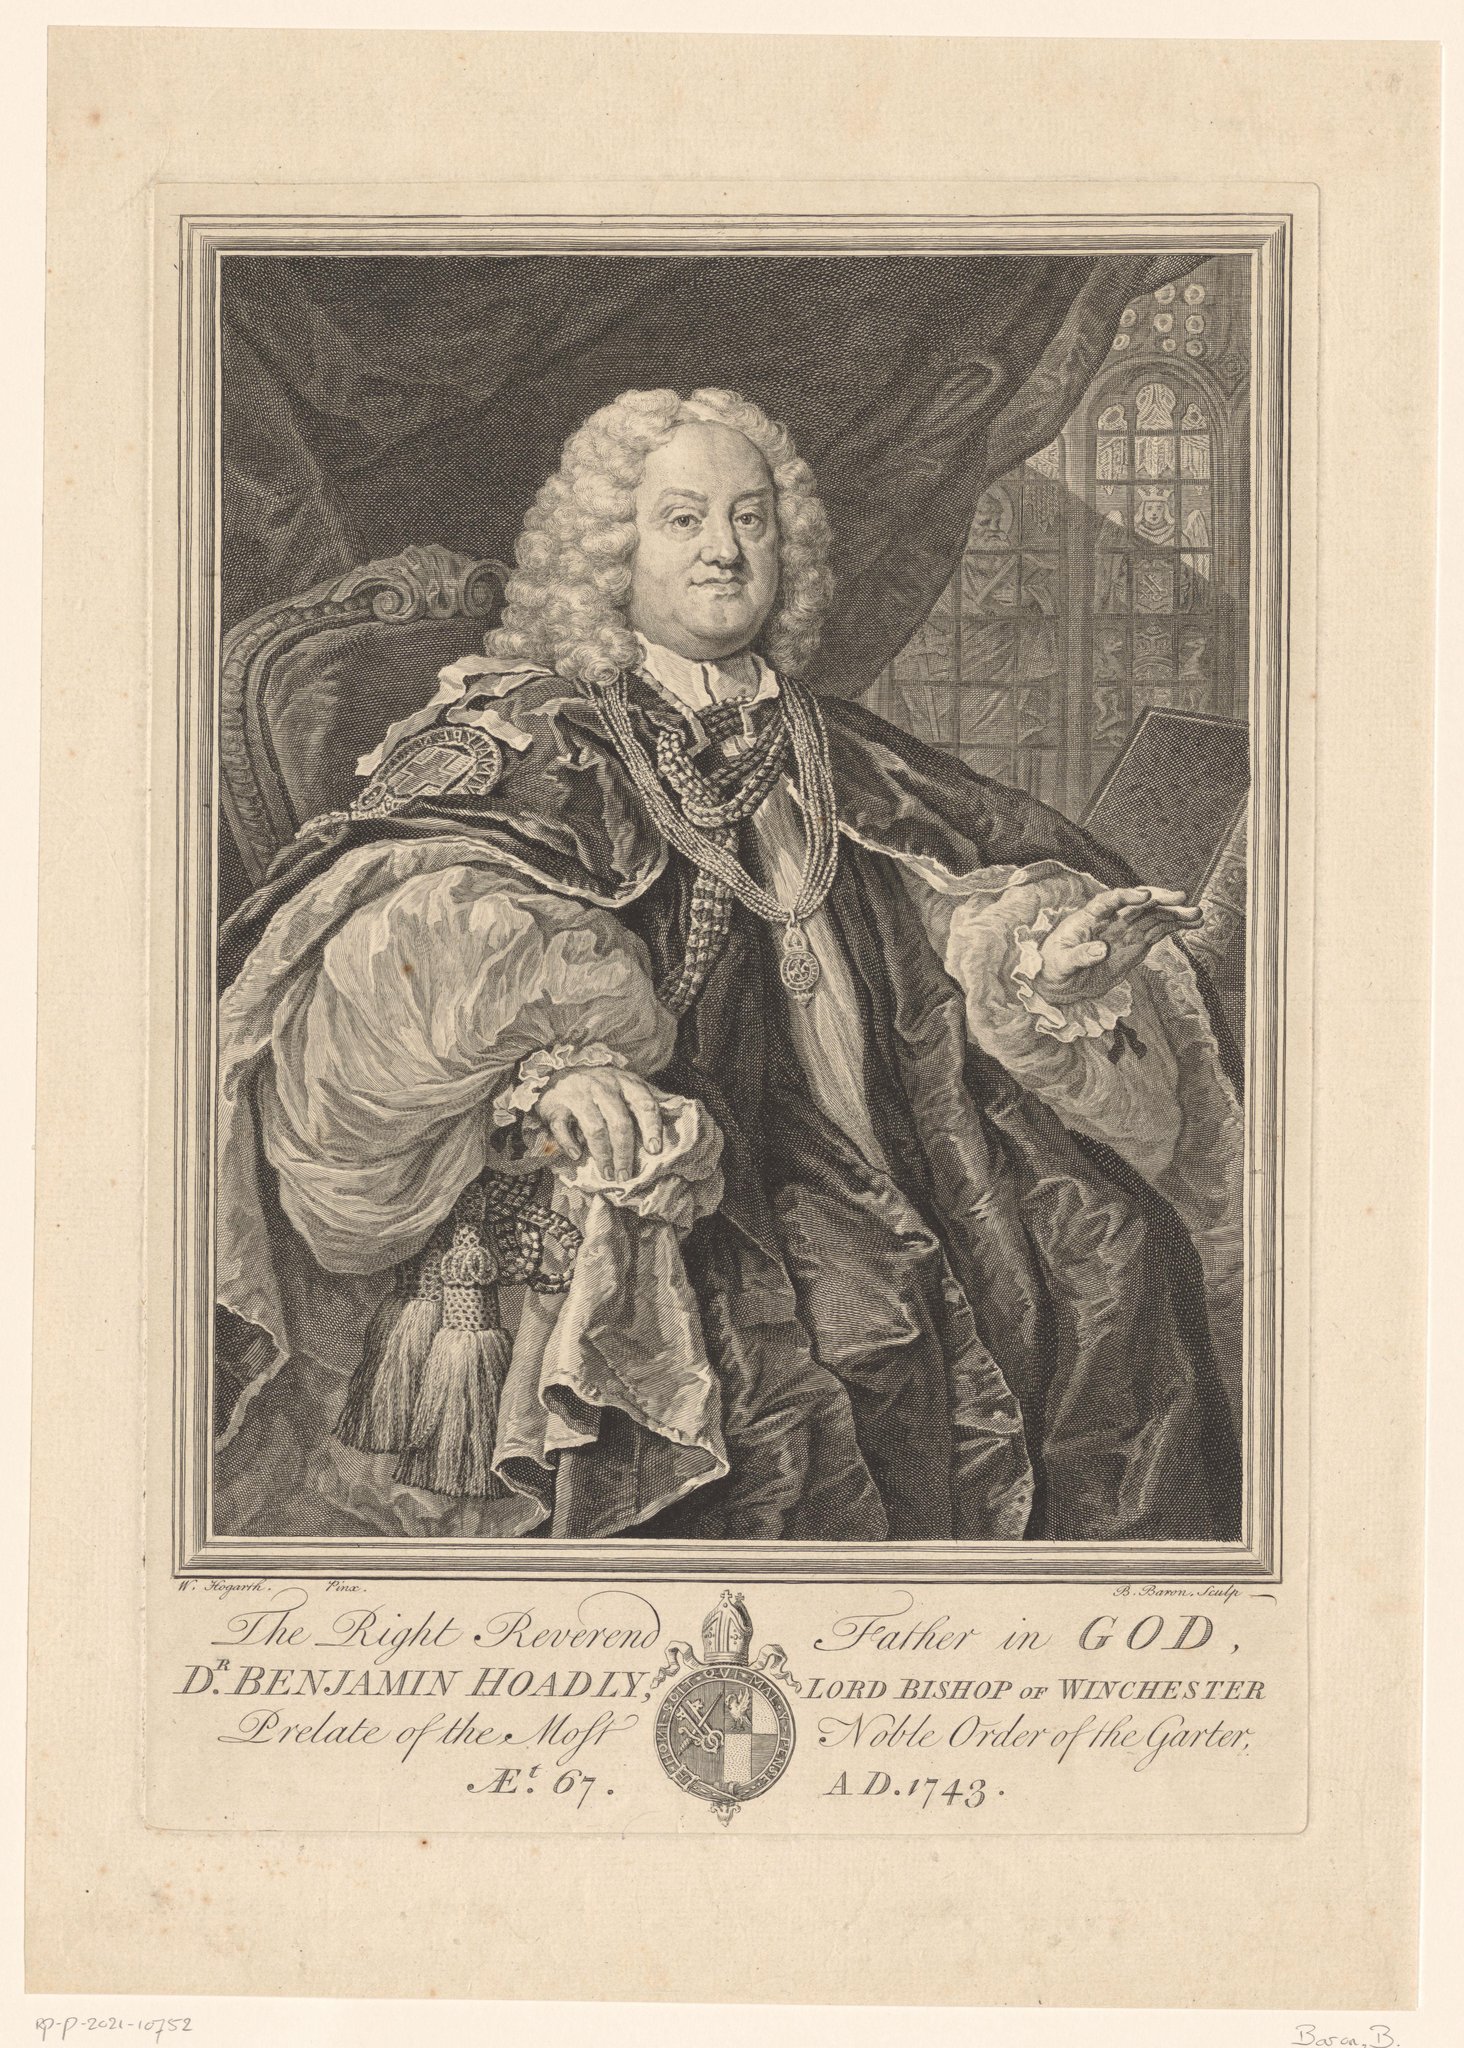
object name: print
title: Portret van Benjamin Hoadly, bisschop van Winchester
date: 1743-1762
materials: paper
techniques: engraving, etching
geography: france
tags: archbishop, bishop, etc. (roman catholic), historical persons, armorial bearing, heraldry